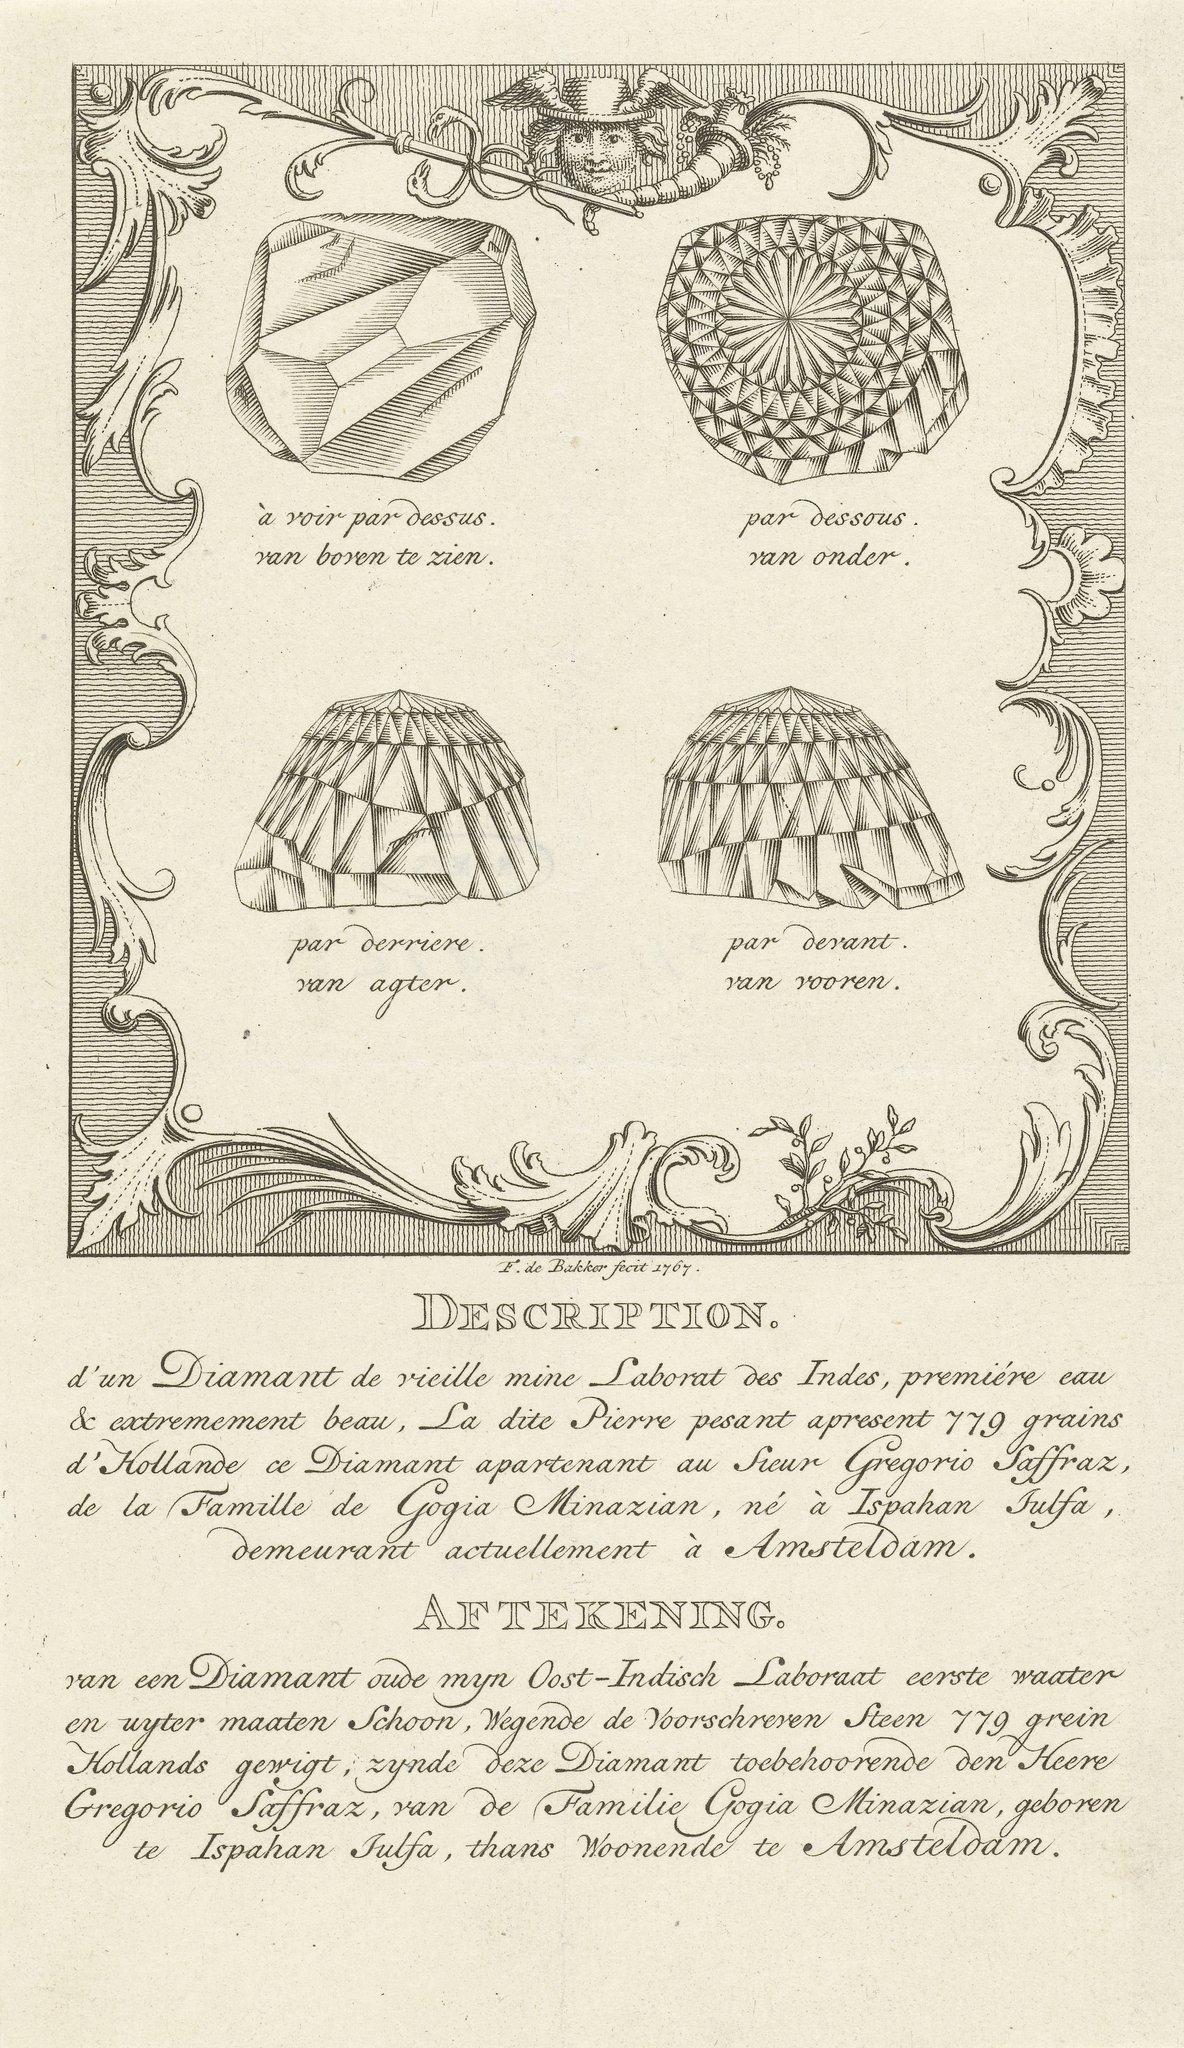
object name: print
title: Vier aanzichten van de Orlov (Orloff) diamant.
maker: frans de bakker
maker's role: print maker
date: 1767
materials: paper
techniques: engraving, etching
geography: amsterdam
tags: precious and semiprecious stones: diamond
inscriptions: collector's mark: Lugt 2228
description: Vier aanzichten van de Orlov (Orloff) diamant. Met een beschrijvend onderschrift in het Frans en Nederlands over de diamant en zijn Iraanse eigenaar Gregorio Saffraz uit Amsterdam. De diamant van 189 karaat werd in 1767 geveild in Amsterdam en verkocht aan graaf Grigory Orlov (1734-1783). Hij gaf de diamant cadeau aan zijn minnares Keizerin Catharina de Grote (1729-1796) en zij liet in 1774 de diamant in de keizerlijke scepter zetten.